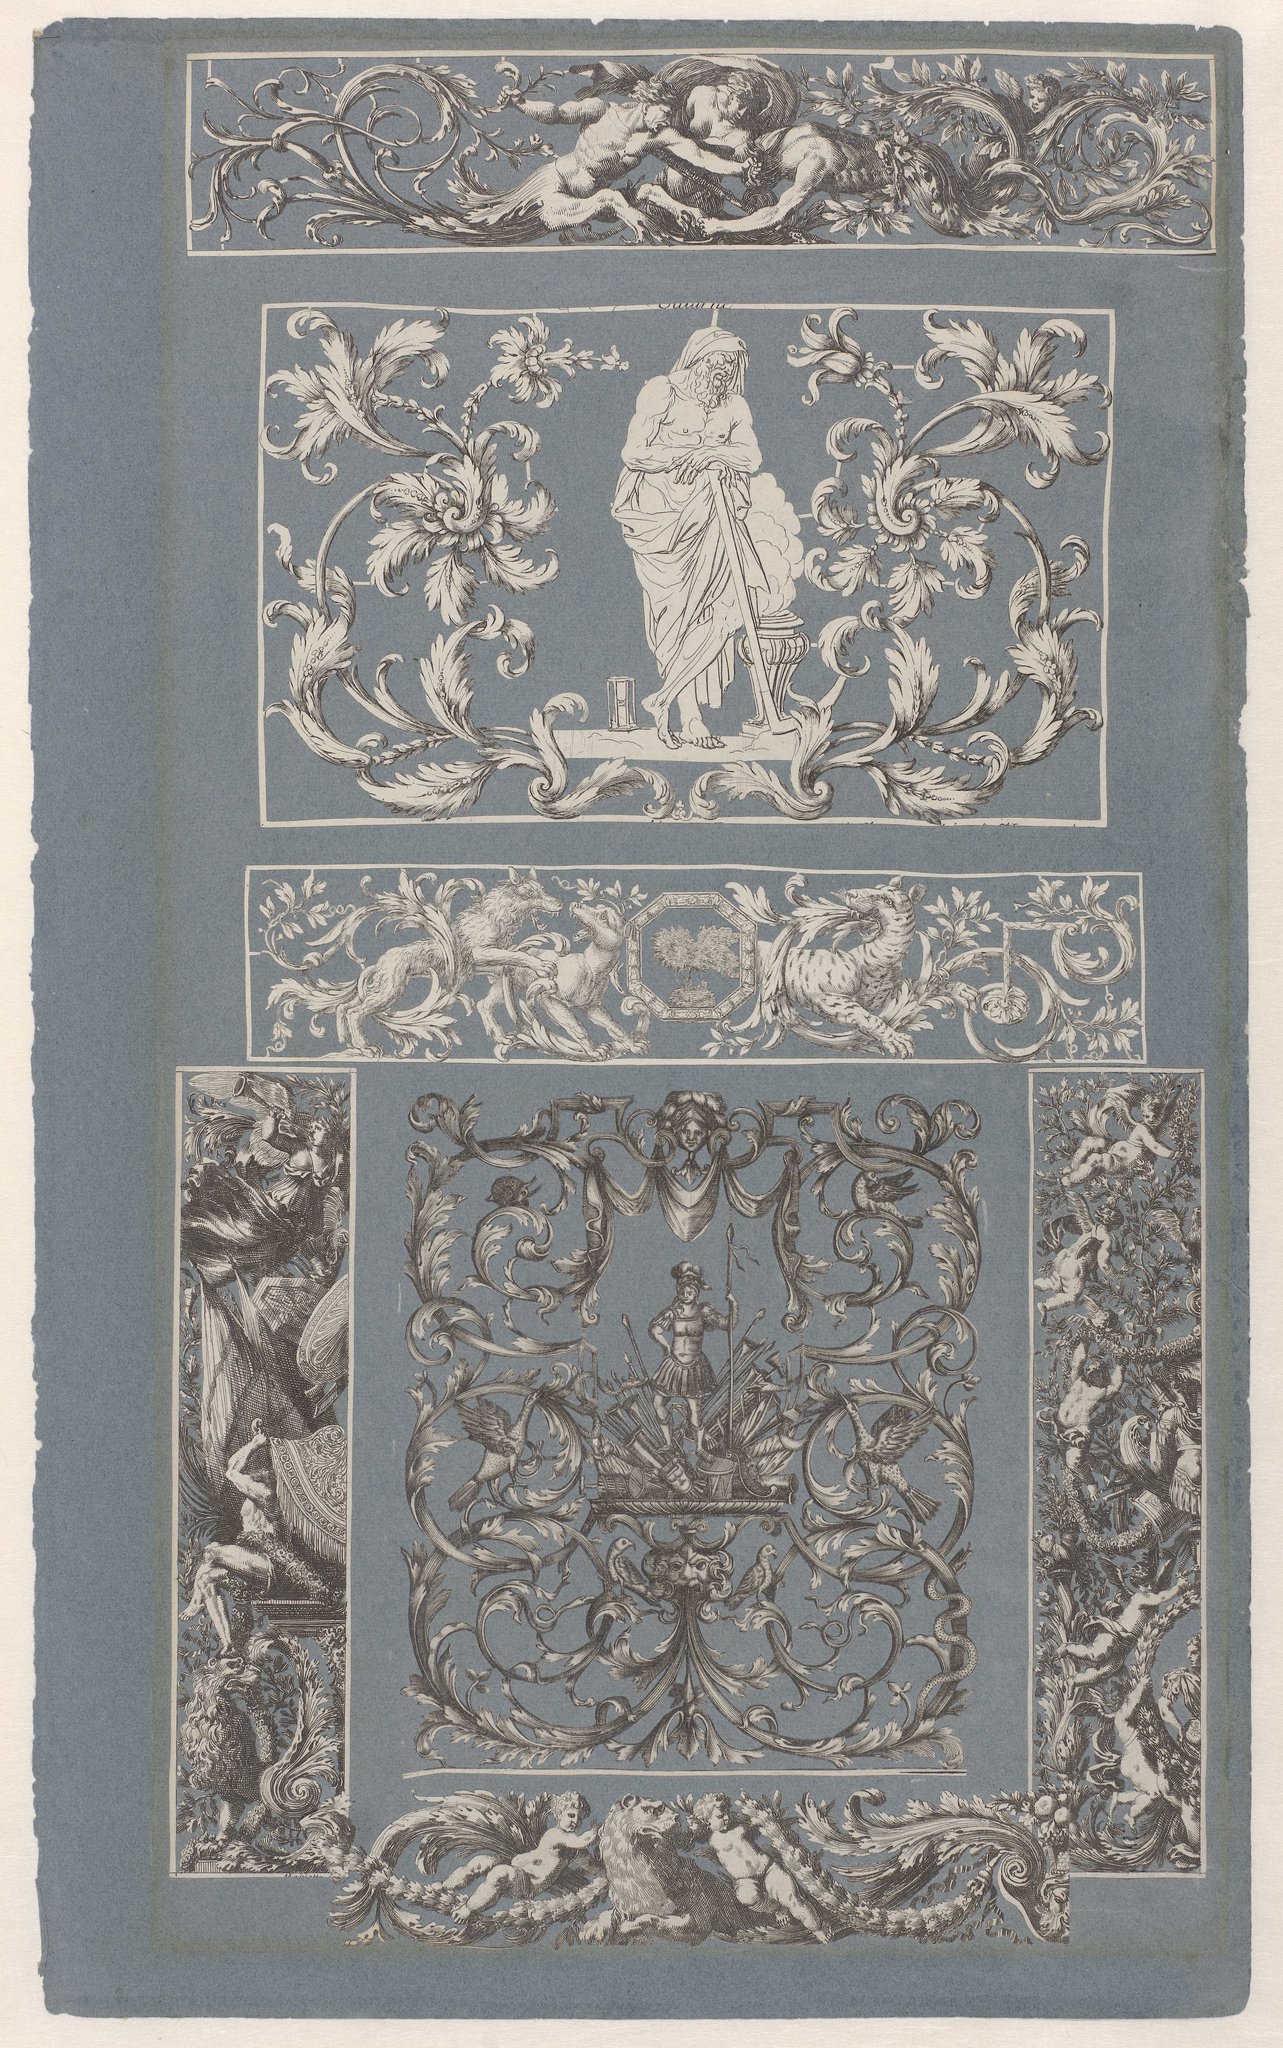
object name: ornament print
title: Collage van uitgeknipte prenten geplakt op albumblad van blauw papier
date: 1690-1720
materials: paper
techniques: engraving, snipping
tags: (story of) saturn (cronus), tendrils ~ ornament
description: Blauw albumblad beplakt met uitgeknipte prenten van verschillende prentmakers. Aan de bovenzijde ranken met drie vechtende halffiguren. Daaronder Saturnus omgeven door ranken. Als derde ranken met drie dieren. Daaronder staat een figuur in harnas op wapens, omgeven door ranken met maskers en vogels. Links onder een engel en een zittende figuur met vlaggen, schilden en een leeuw. Midden onder twee putti met een leeuw en ranken. Rechts onder putti met wapens, guirlandes en ranken.